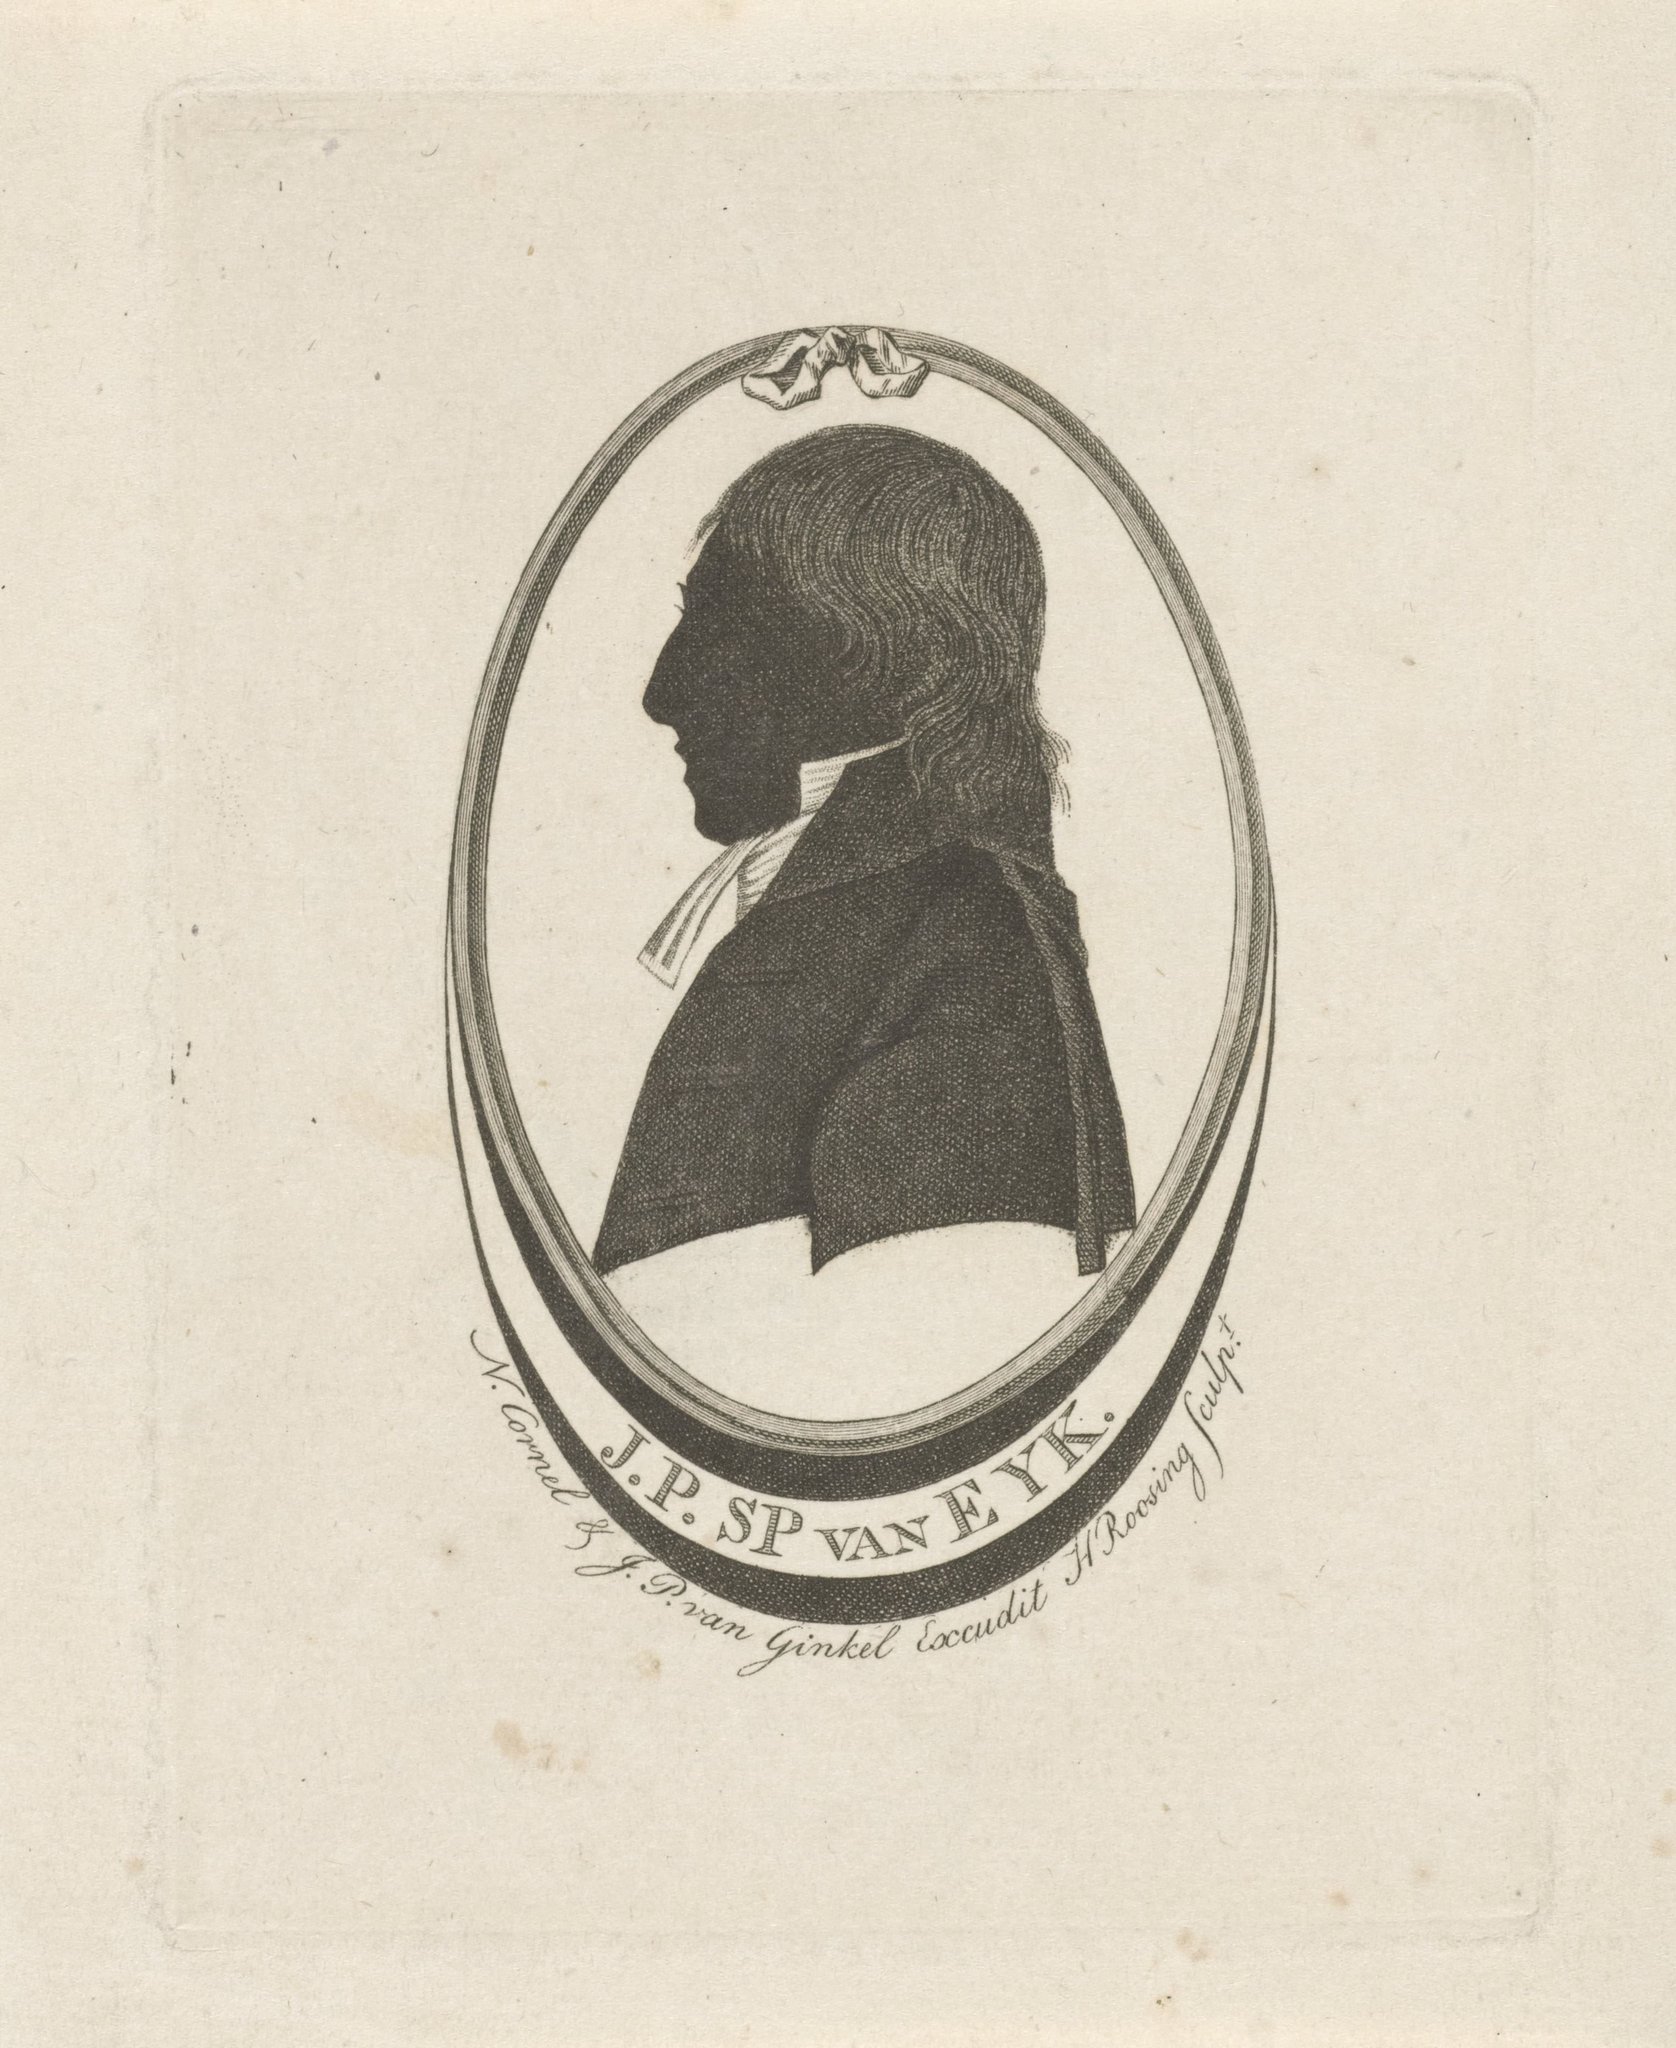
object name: print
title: Silhouetportret van J.P.SP. van Eyk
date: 1794-1800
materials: paper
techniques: etching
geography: rotterdam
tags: oosterbeek, predikant, jacobus petrus sprenger van eyk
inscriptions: collector's mark: Lugt 2228